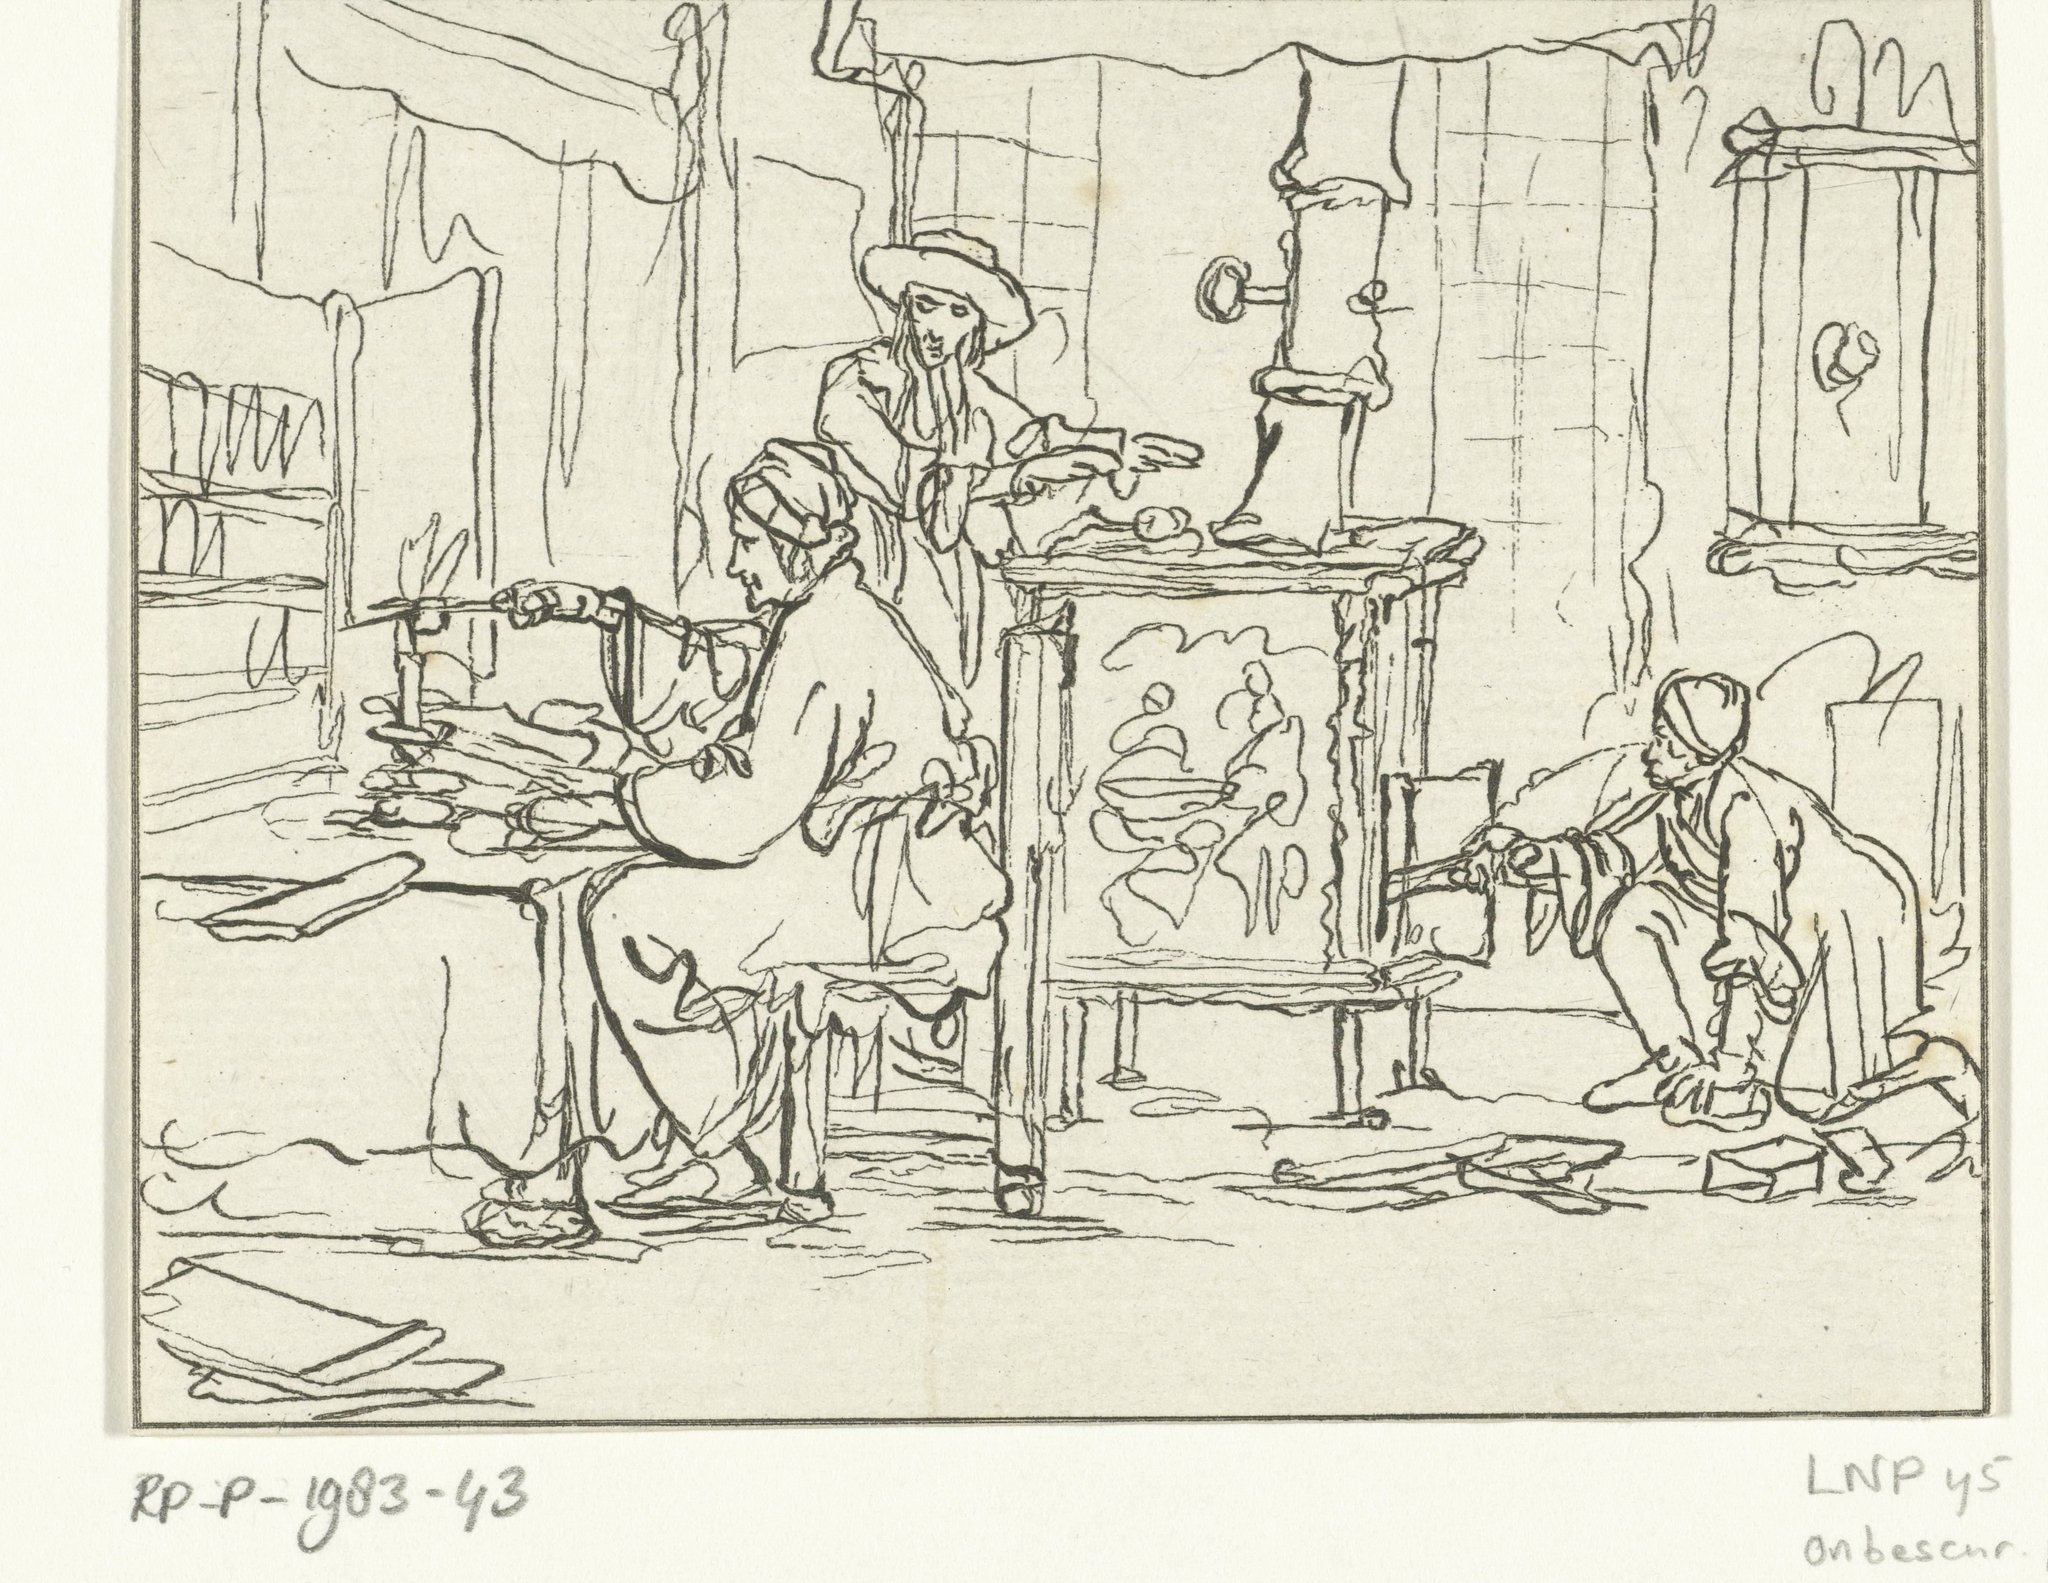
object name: print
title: Kaarssnuitende man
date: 1782-1787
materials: paper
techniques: etching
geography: amsterdam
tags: snuffers, warming oneself at a fire (or hearth, stove, fire-pan, brazier), heating stove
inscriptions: inscription: ‘Geoff : aan mijn waarde vriend de Heer Hemsterhuys / J: Luyken del Ploos v AMstel Fec’, collector's mark: Lugt 2760, collector's mark: Lugt 2228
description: Interieur met een zittende man, die een kaars dooft. Bij de kachel een staande man, die zijn handen warmt, en een ander die het vuur opstookt.